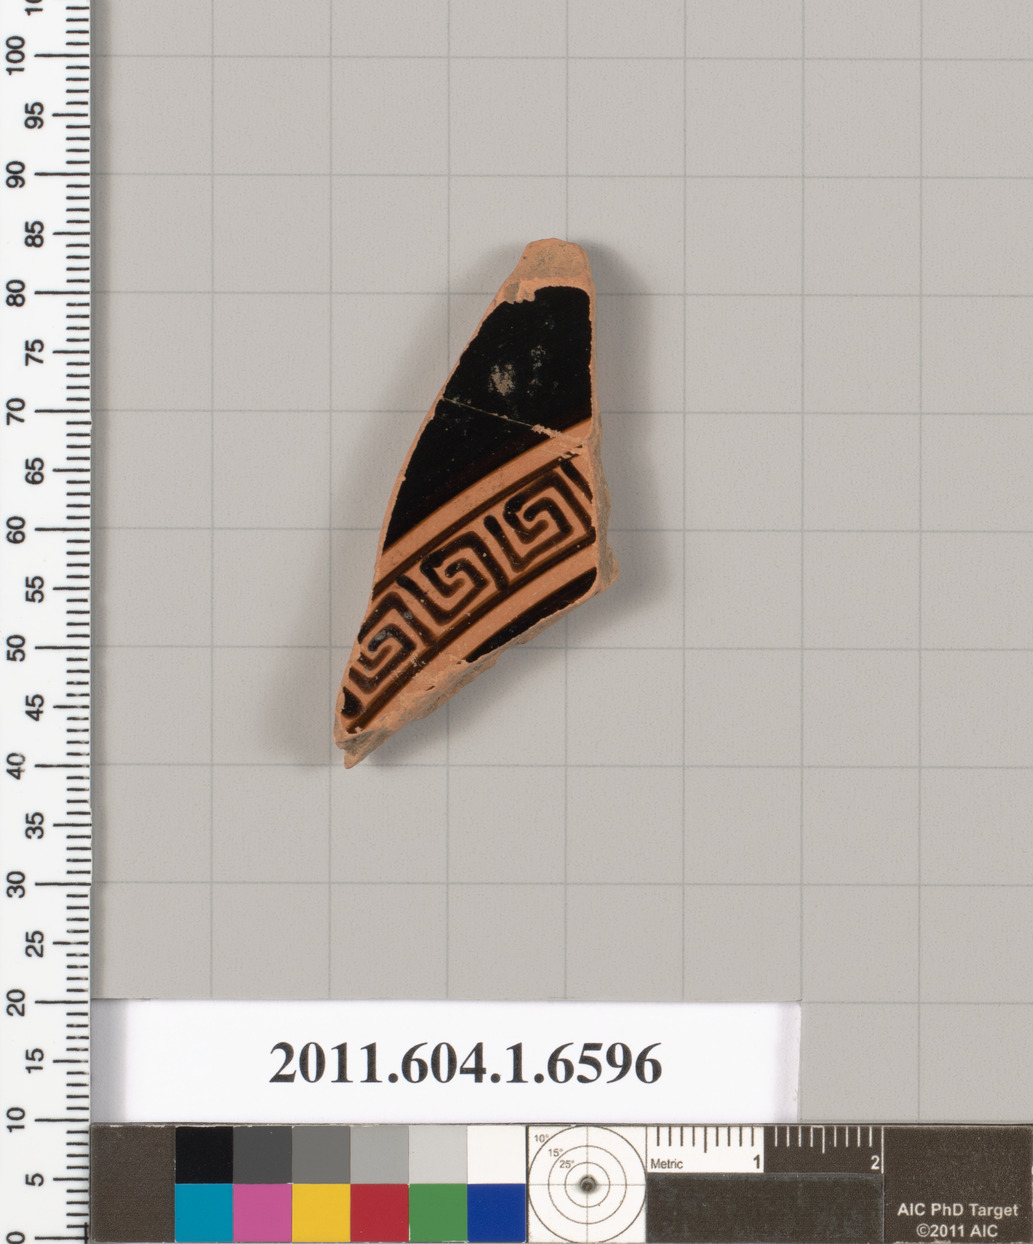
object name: kylix fragment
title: Terracotta fragment of a kylix (drinking cup)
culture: greek, attic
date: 490-480 BCE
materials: terracotta